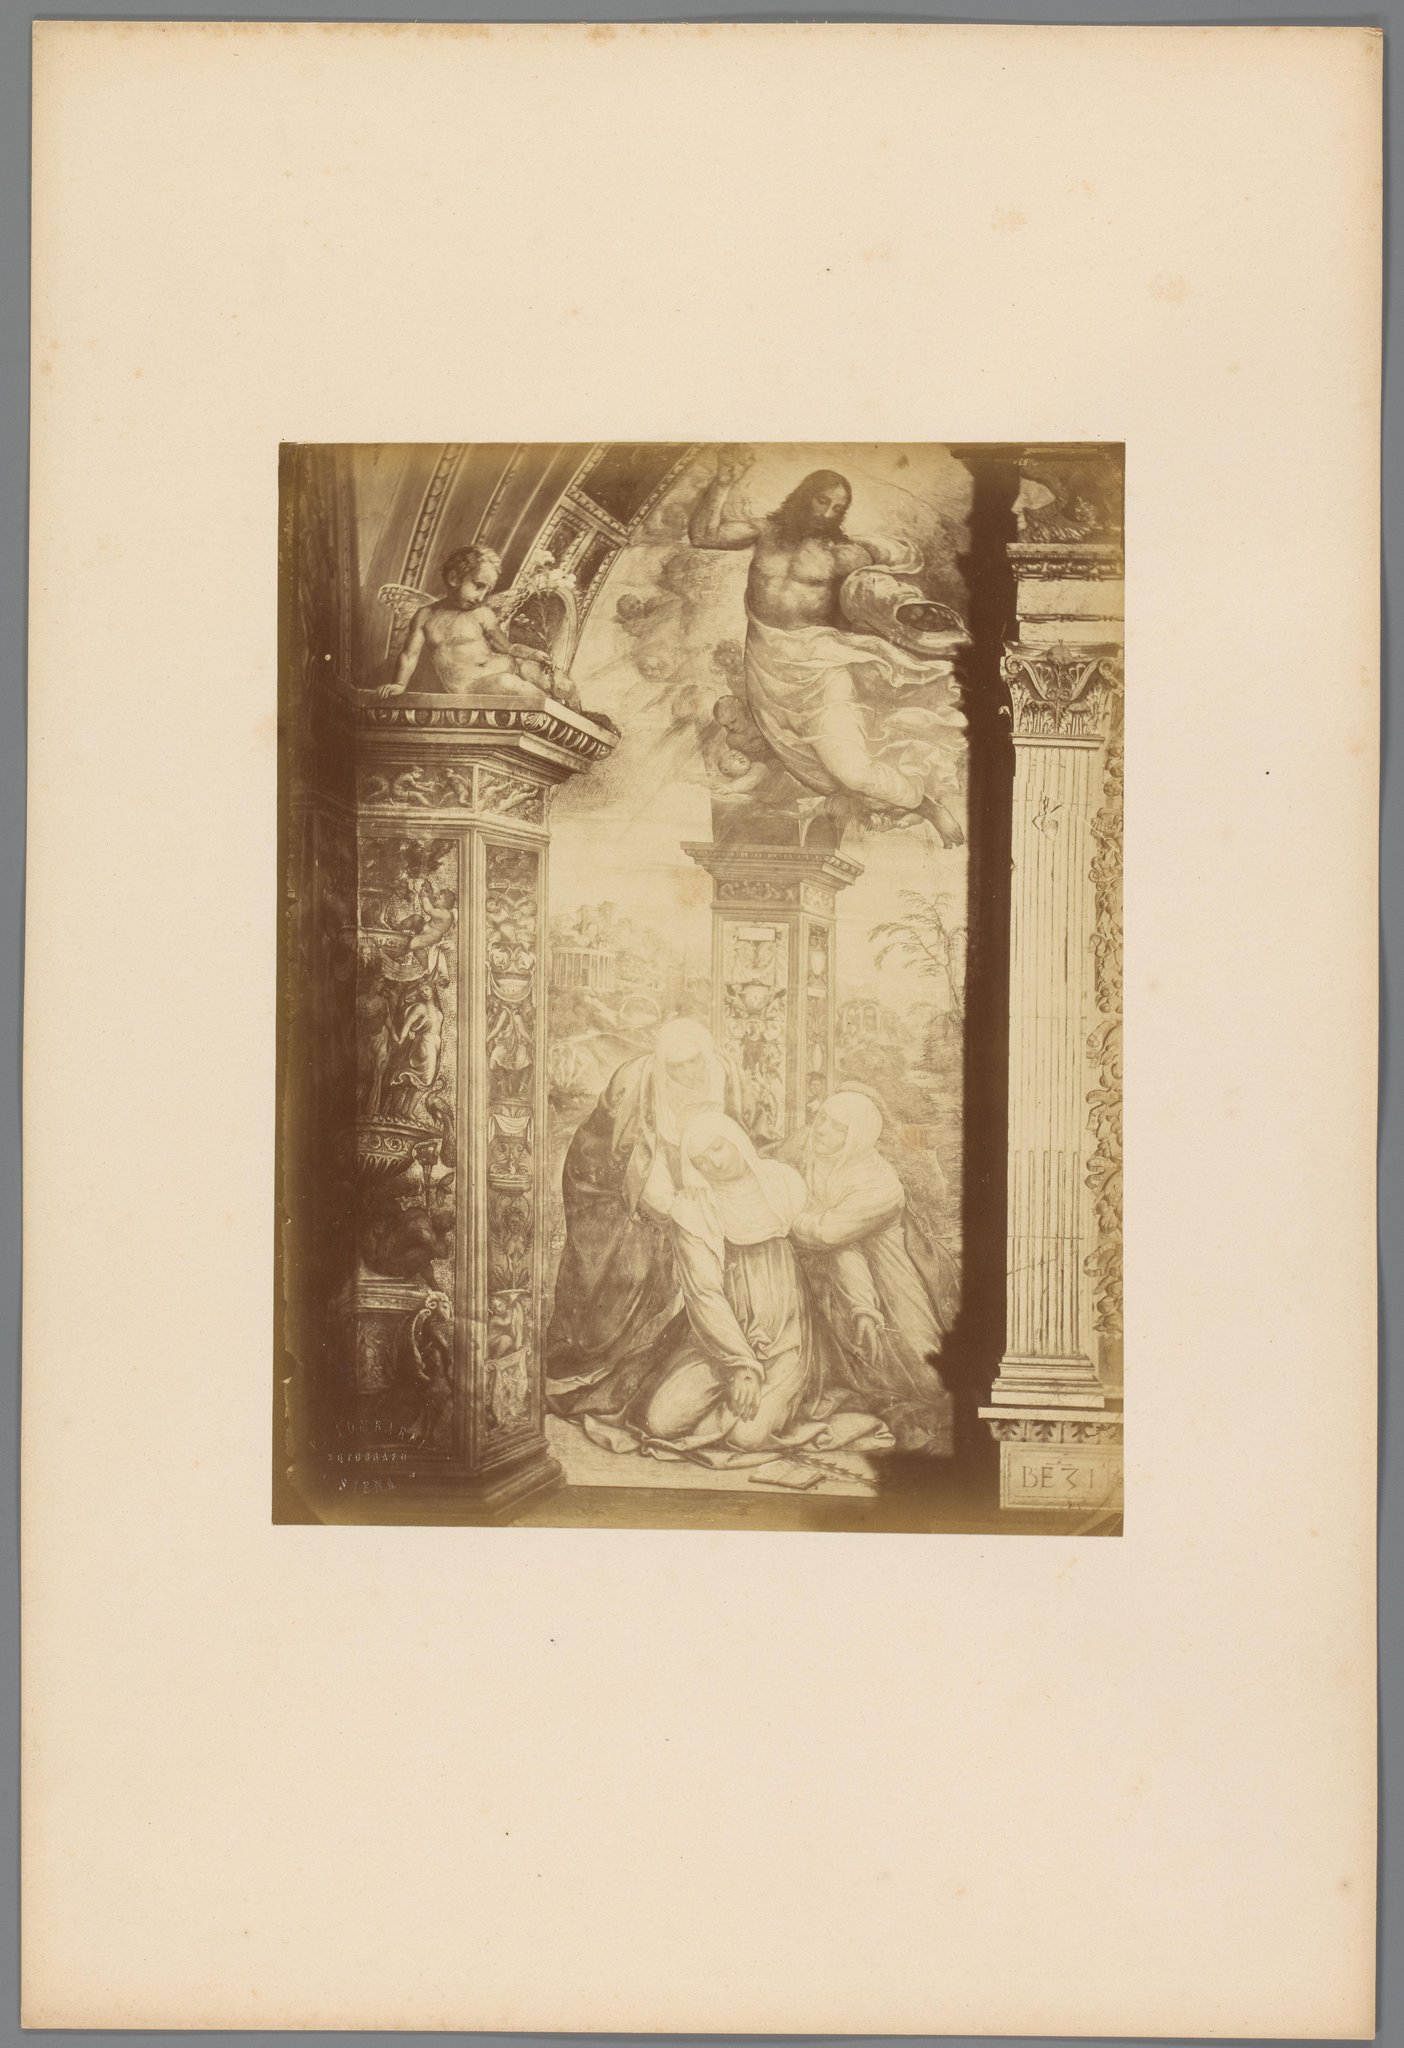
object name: photograph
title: Fotoreproductie van het fresco De stigmata van Sint-Catherine door Il Sodoma in de Sint-Dominicusbasiliek te Siena, Italië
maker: paolo lombardi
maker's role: fotograaf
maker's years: 1827-1890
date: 1851-1890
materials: cardboard, paper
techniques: albumen print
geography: siena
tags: wall-covering, st. catherine of siena, kneeling before a crucifix, or swooning into the arms of two nuns, receives the stigmata